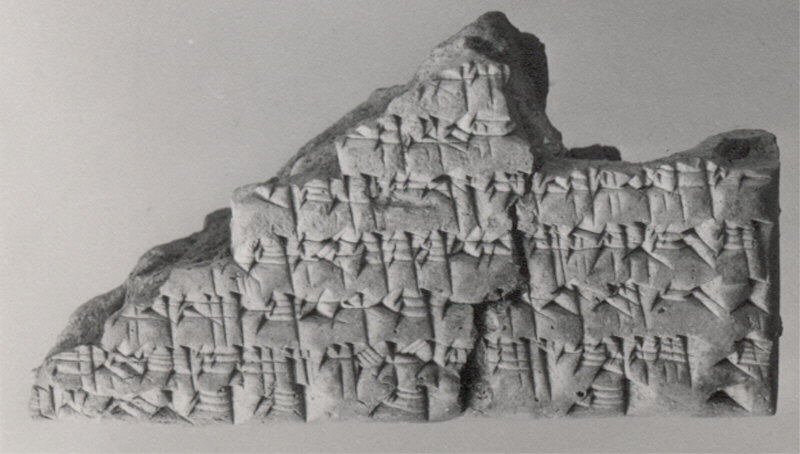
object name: cuneiform tablet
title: Cuneiform tablet: fragment of a dialogue document concerning a dowry conversion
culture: achaemenid or babylonian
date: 700-301 BCE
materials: clay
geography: mesopotamia